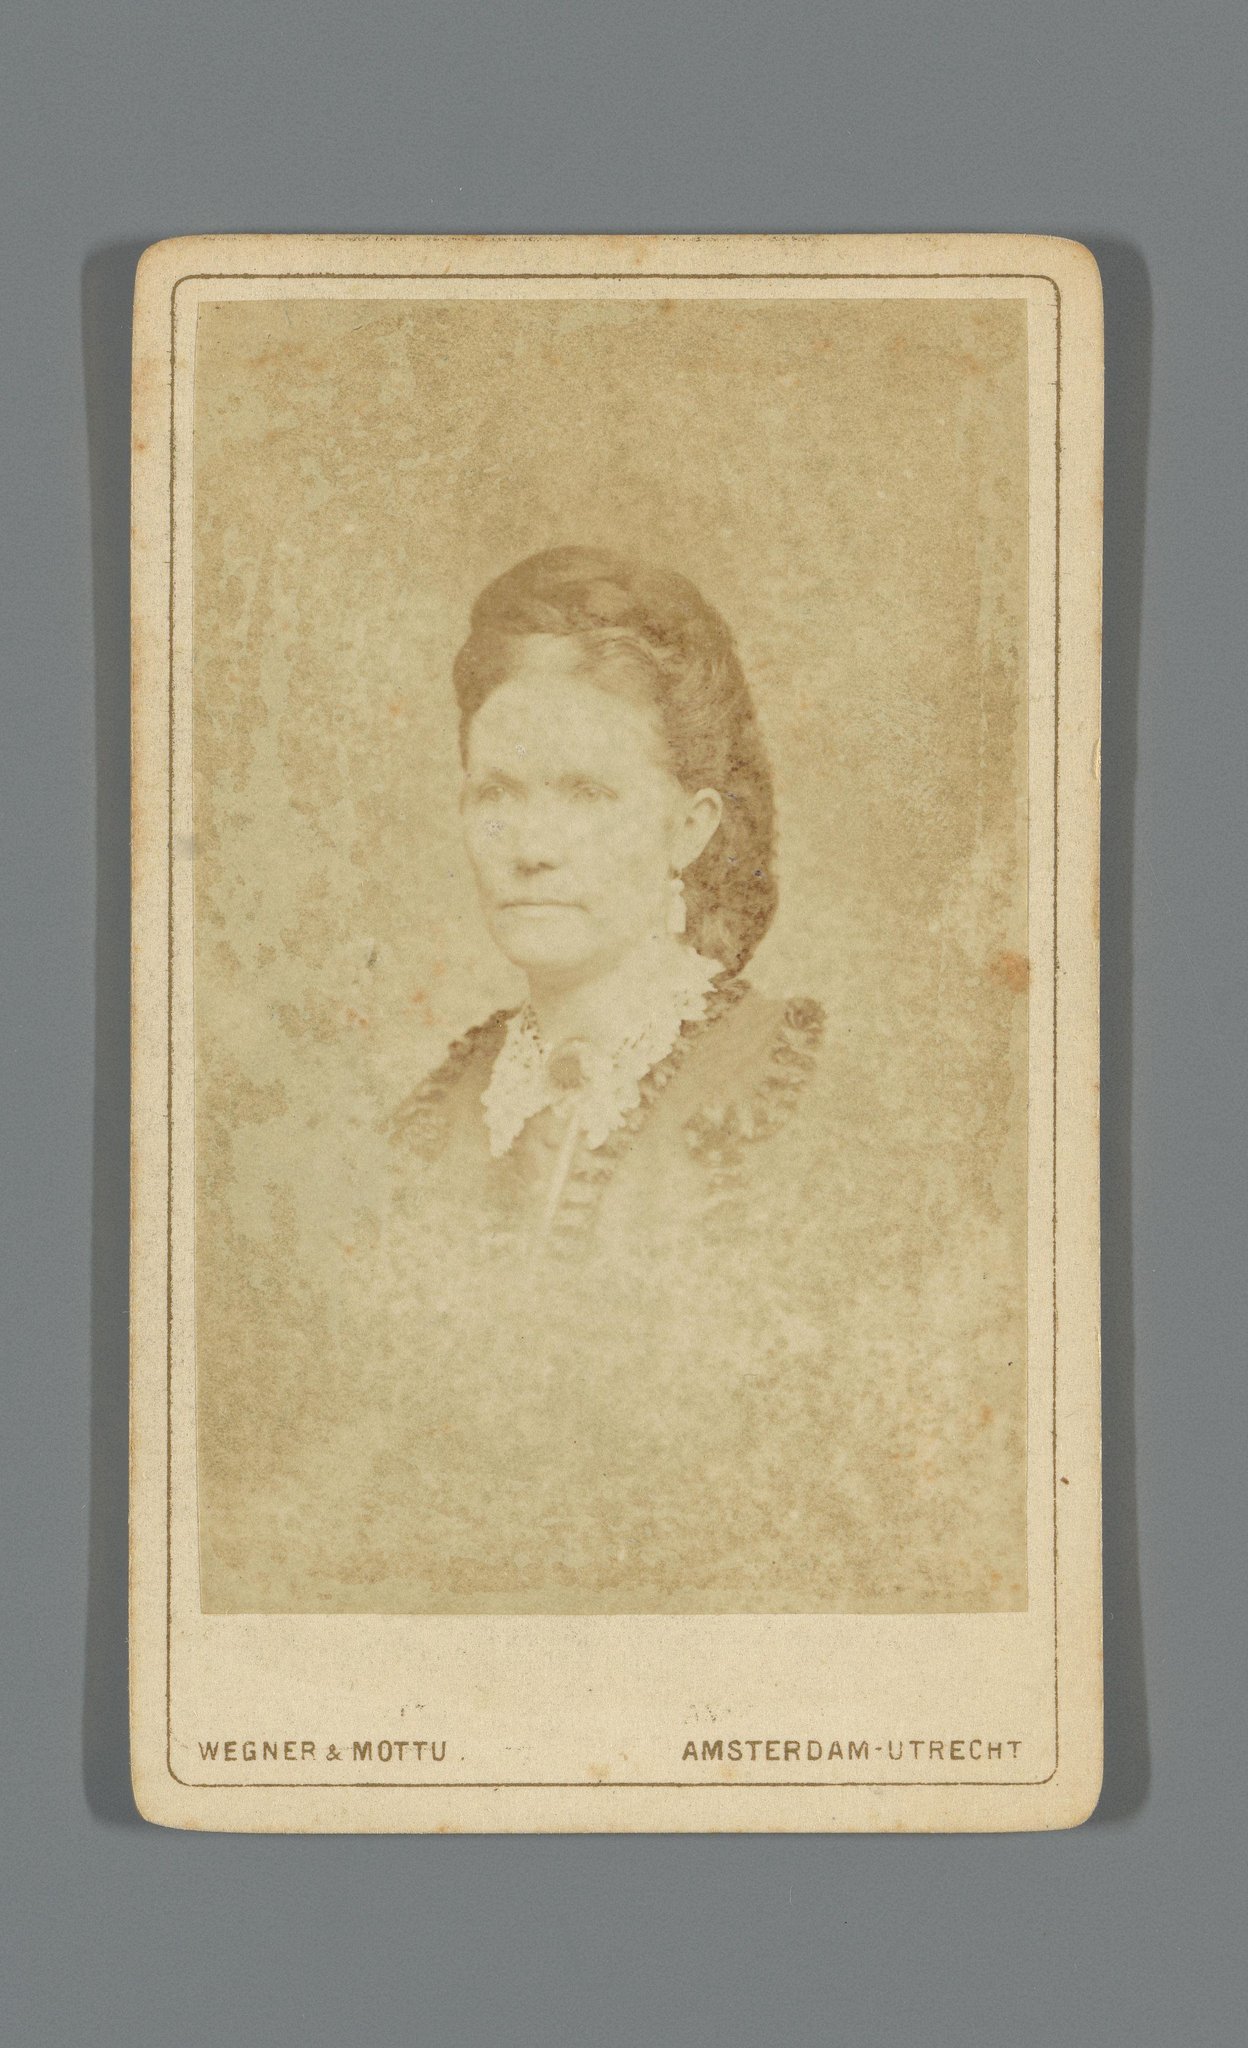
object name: photograph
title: Portret van Goverta Machtella Fontein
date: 1860-1875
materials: cardboard, photographic support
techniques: photography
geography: netherlands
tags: surabaya, haarlem, historical persons - bb - woman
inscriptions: annotation: ‘Gov. TvB-Fonteyn’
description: Portret van Goverta Machtella Fontein, eerste echtgenote van jhr. Hendrik Teding van Berkhout sr.